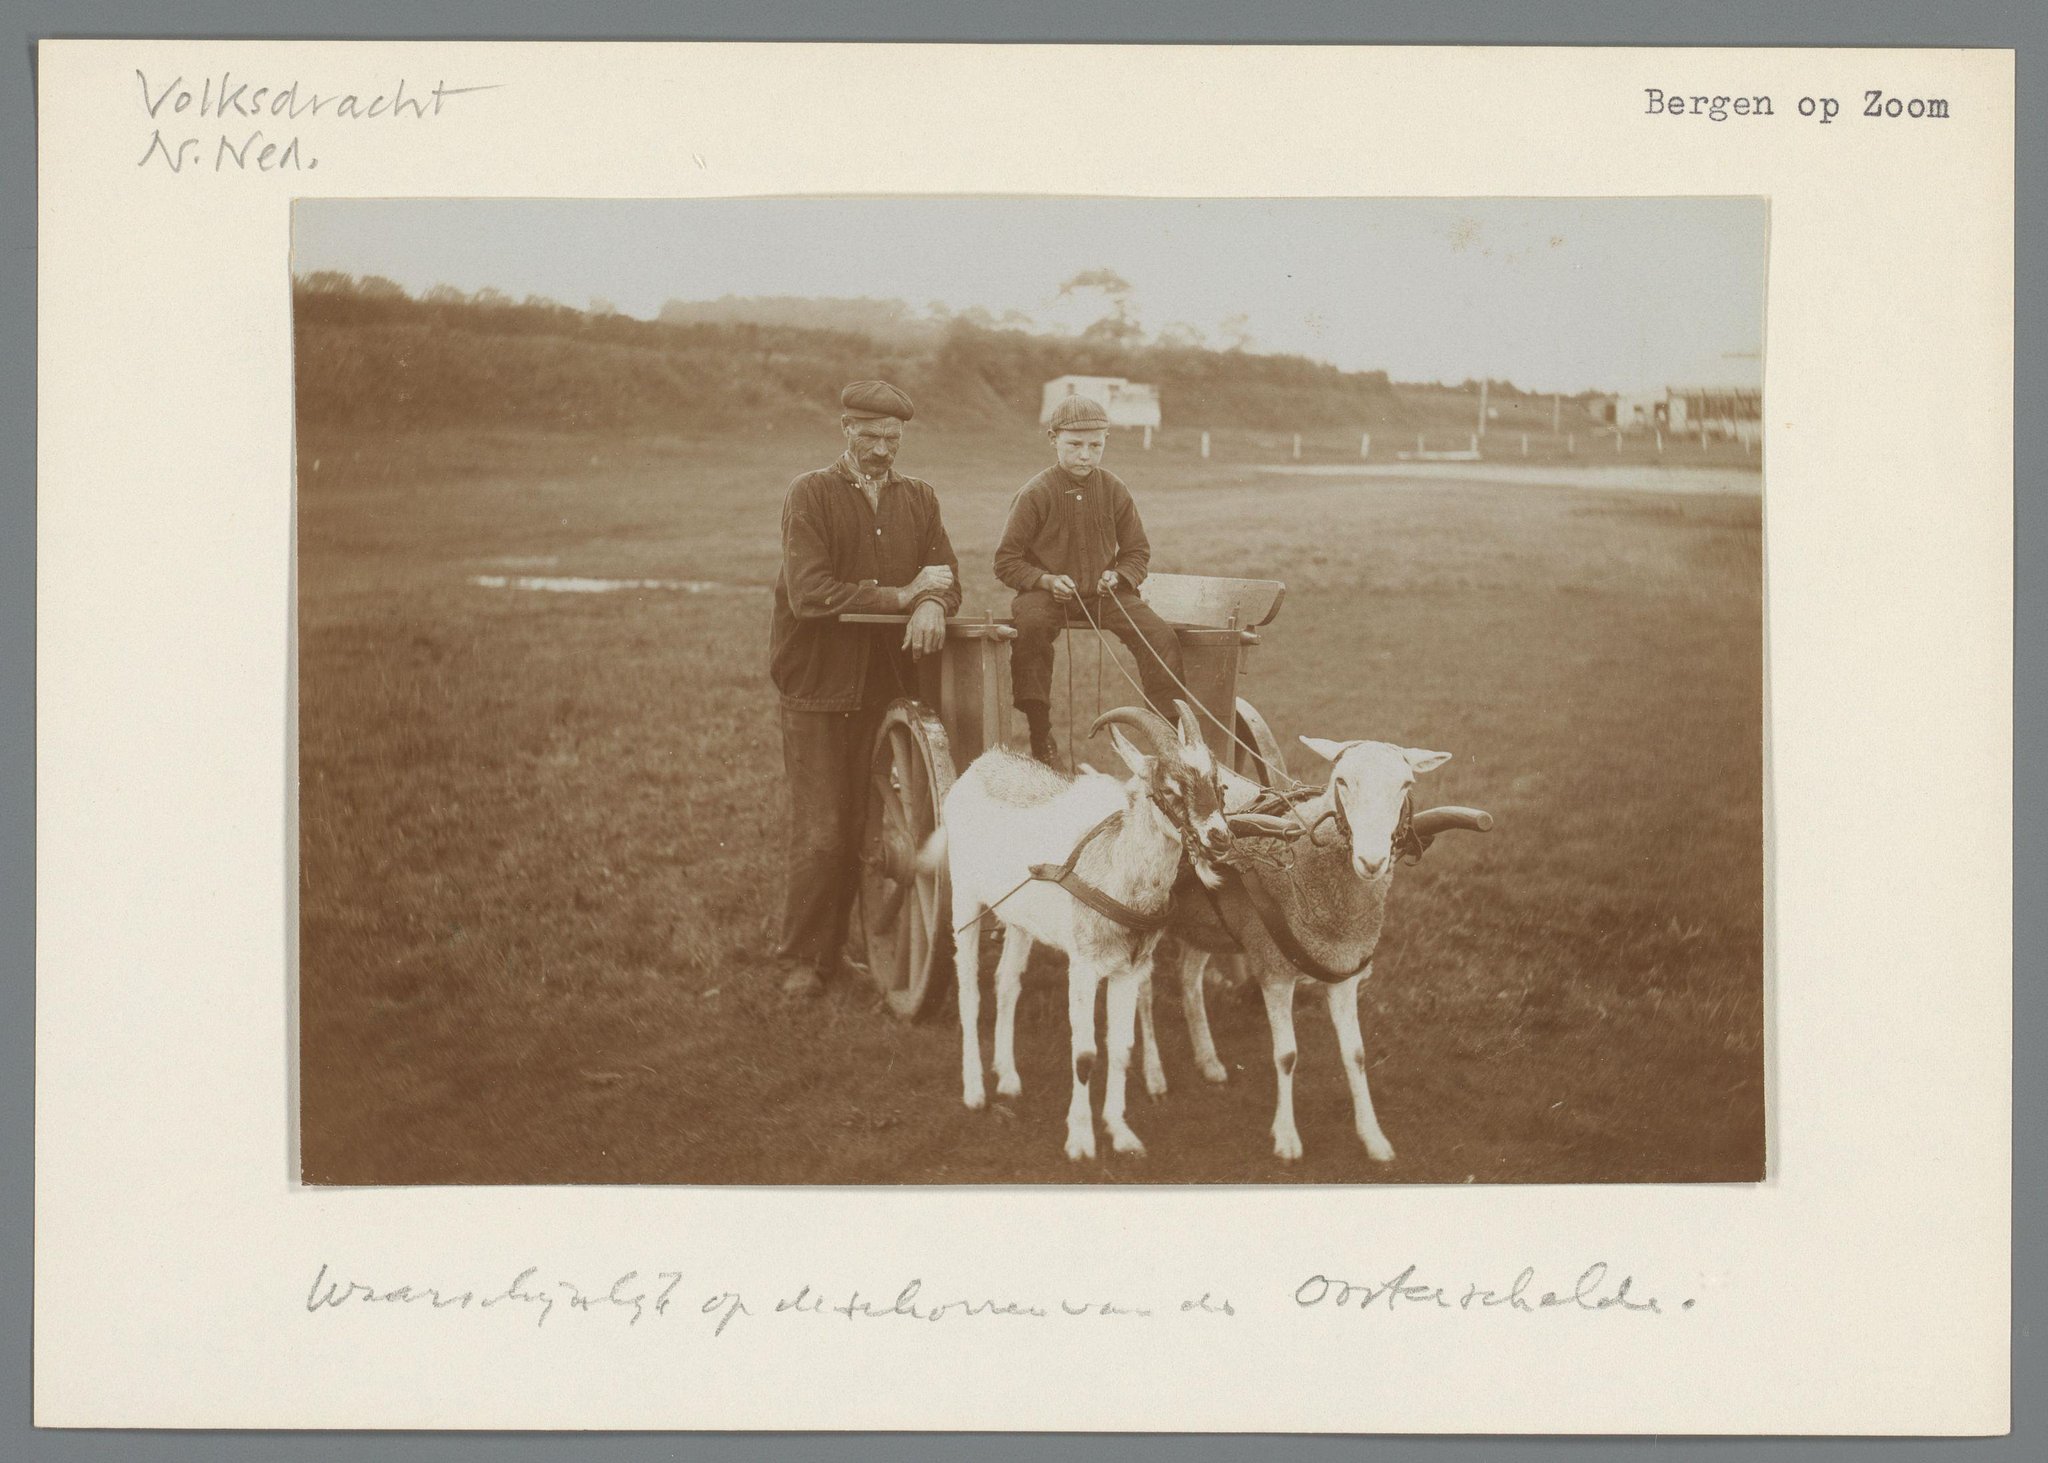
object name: photograph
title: Jongen op de bok van een kar getrokken door geiten, man staat ernaast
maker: Anonymous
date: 1880-1920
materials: paper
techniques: collodion silver print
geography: bergen op zoom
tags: river, child, historical persons, folk costume, regional costume, bergen op zoom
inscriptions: inscription: ‘waarschijnlijk op de schorren van de oosterschelde’, number: ‘- 527004’, inscription: ‘Volksdracht/ N.Ned.’, number: ‘31.673’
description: De foto is waarschijnlijk genomen op de schorren van de Oosterschelde, een buitendijks gebied dat alleen bij springtij onder water komt te liggen.